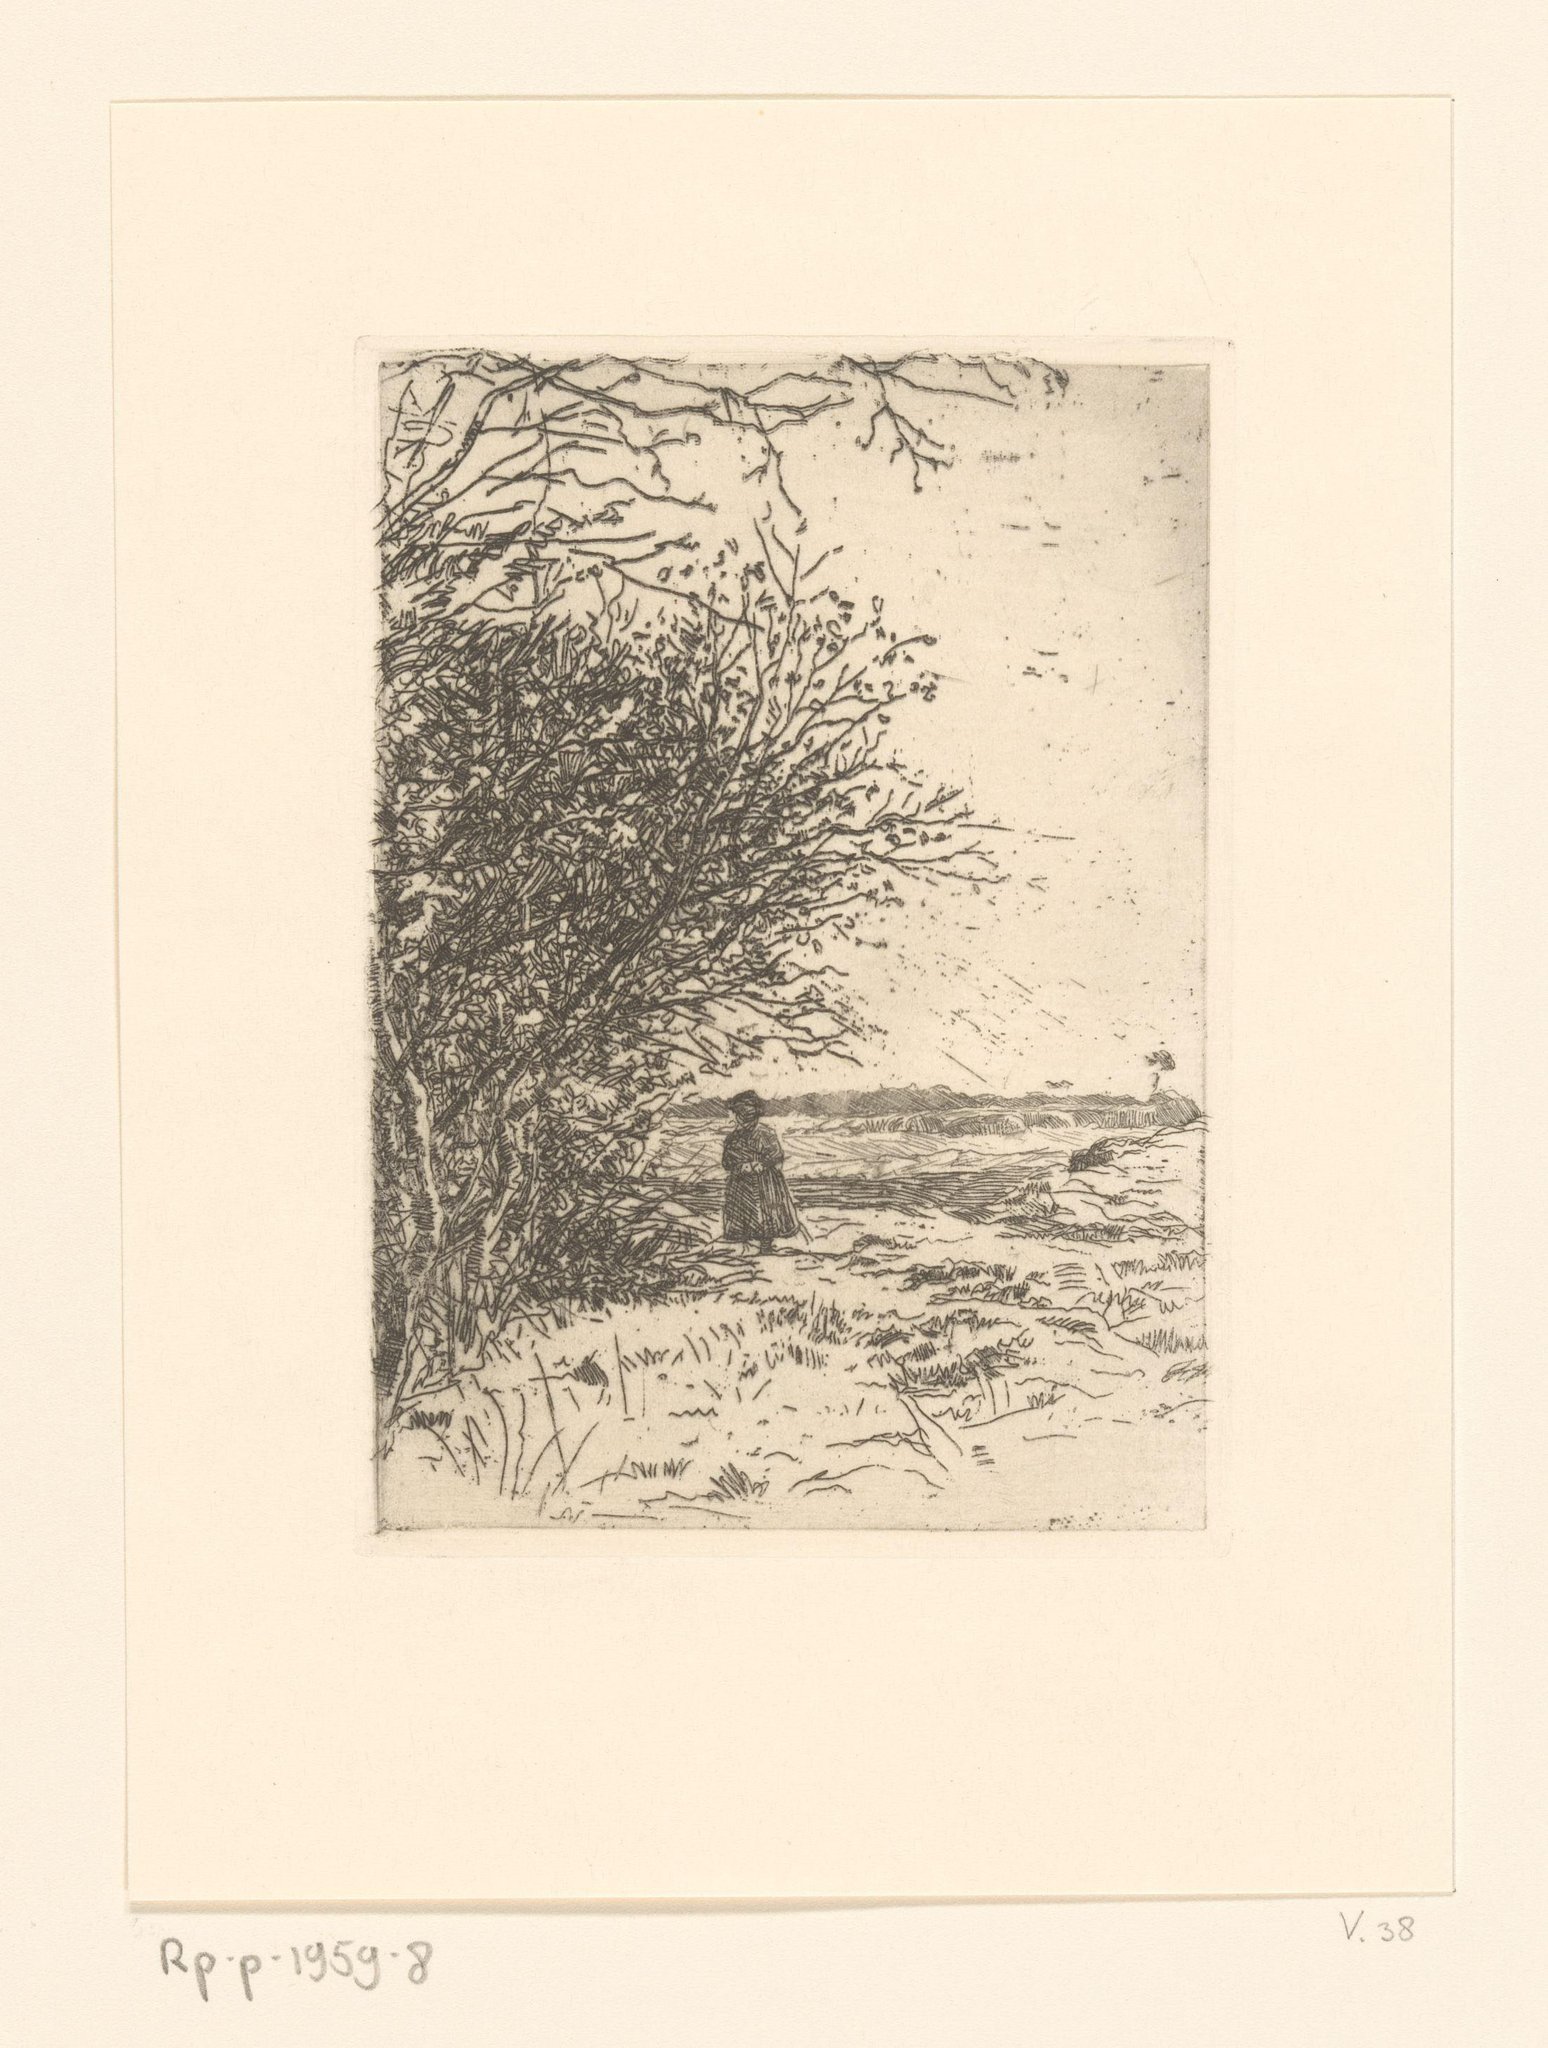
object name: print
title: Vrouw in een landschap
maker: jan veth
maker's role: designer, draughtsman, painter, print maker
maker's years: 1864-1925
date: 1888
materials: paper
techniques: etching, intaglio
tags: meadow, pasture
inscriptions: collector's mark: Lugt 2228